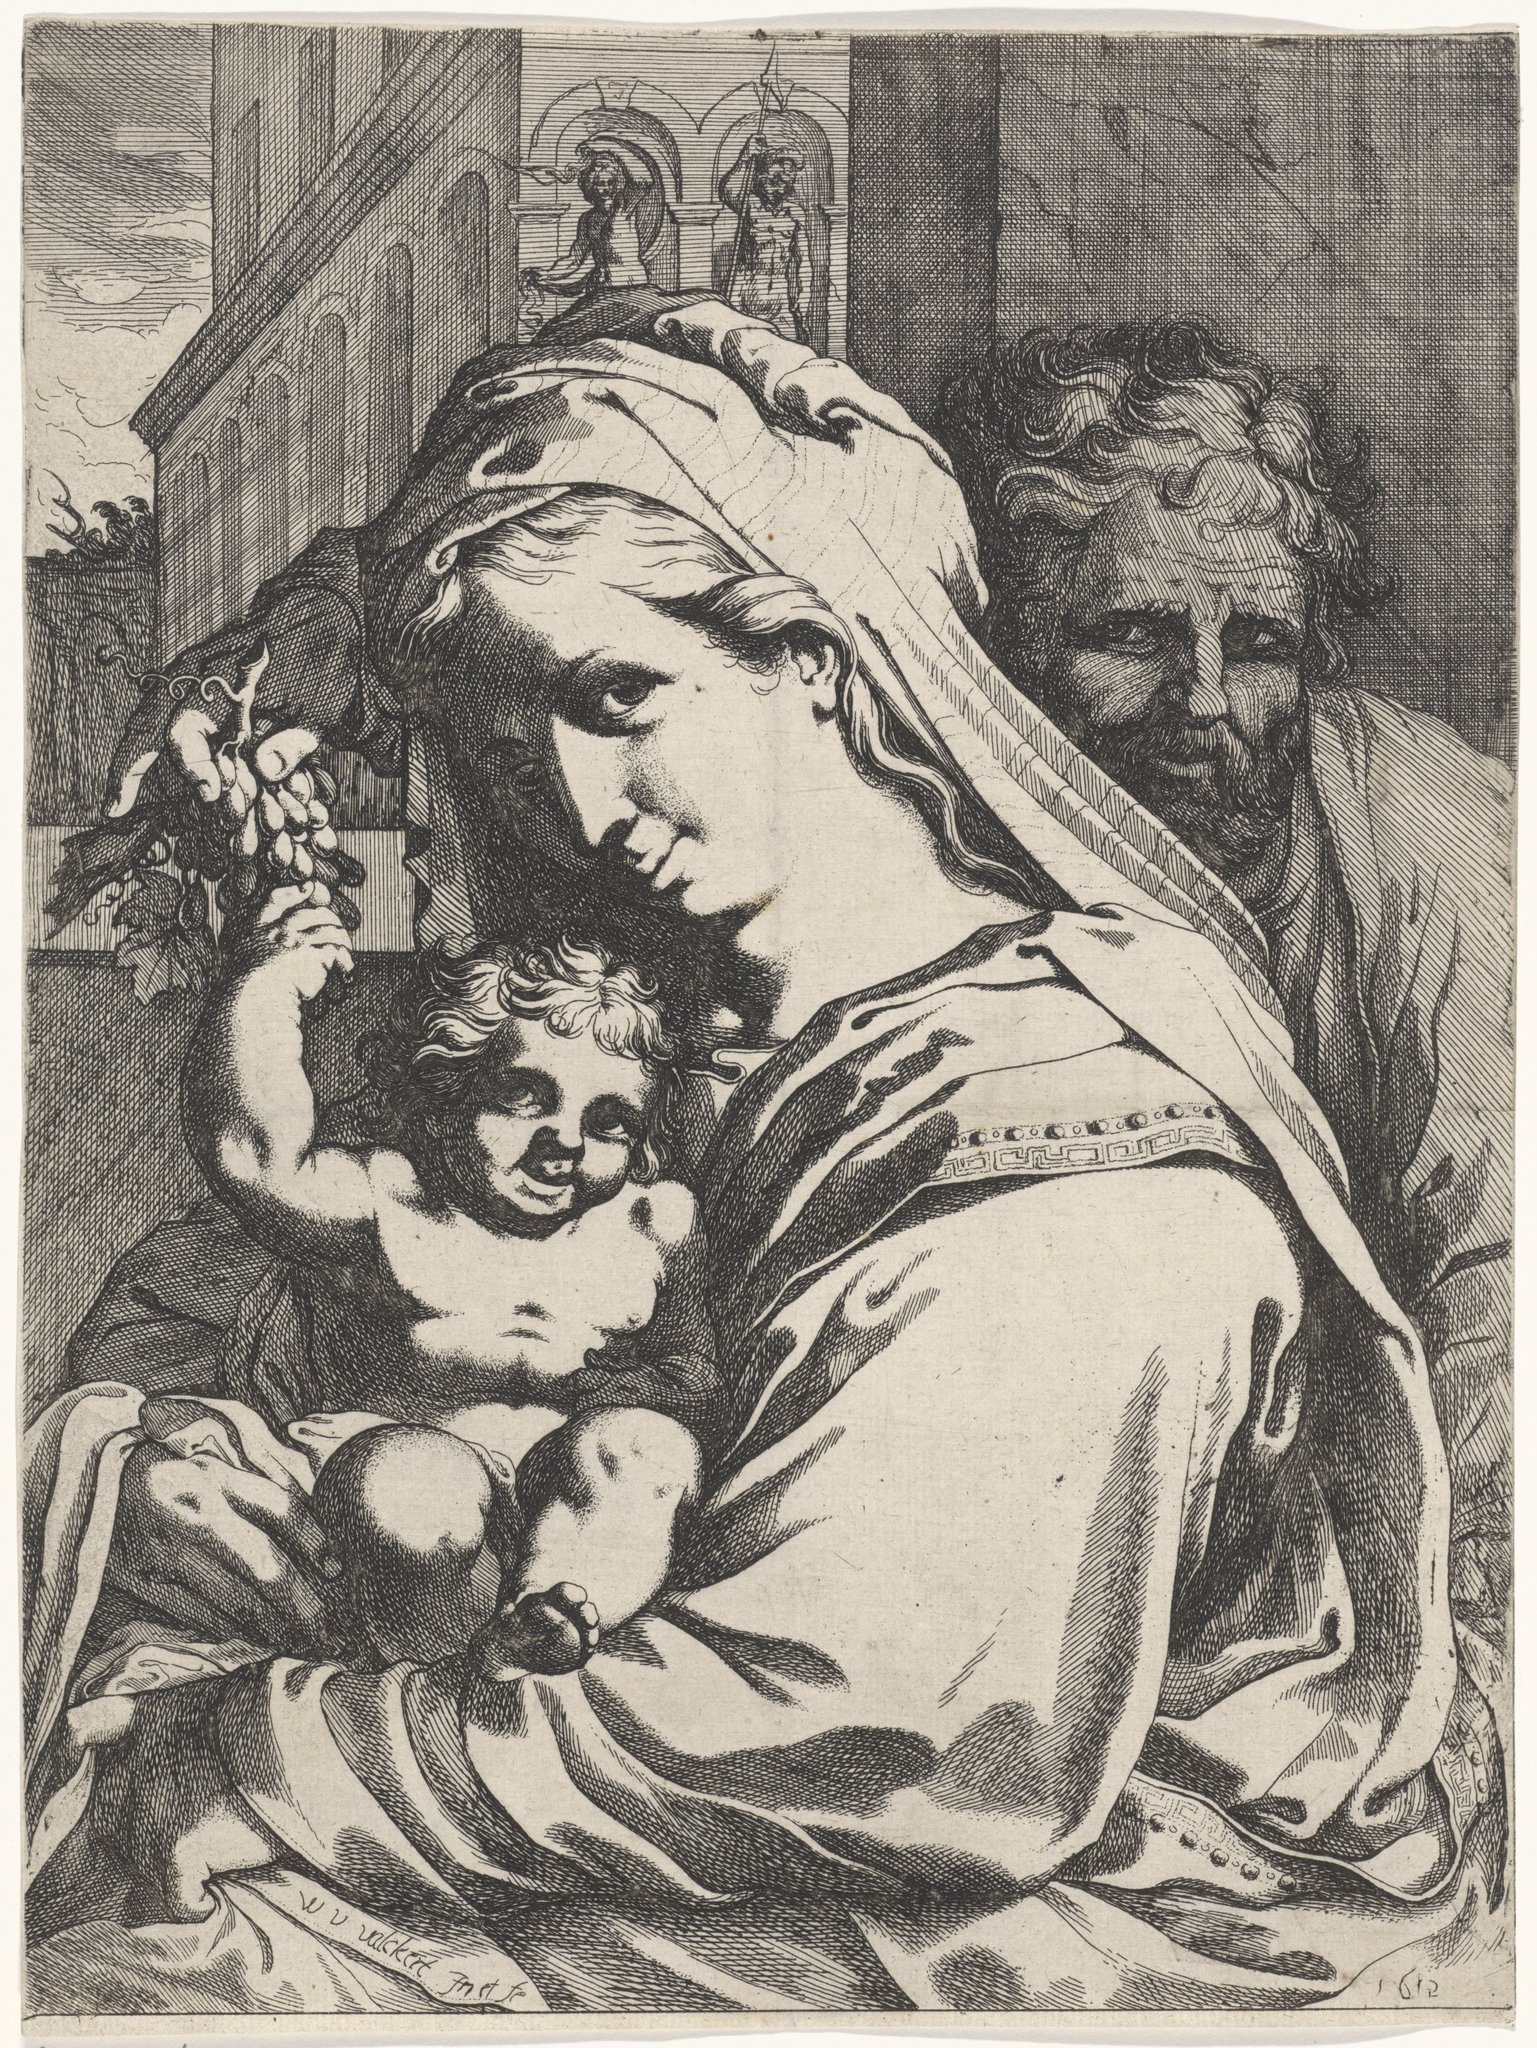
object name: print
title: Heilige Familie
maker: werner van den valckert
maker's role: draughtsman, painter, print maker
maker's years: 1580-1627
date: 1612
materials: paper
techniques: etching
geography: the hague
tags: holy family, and derived representations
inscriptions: collector's mark: Lugt 240